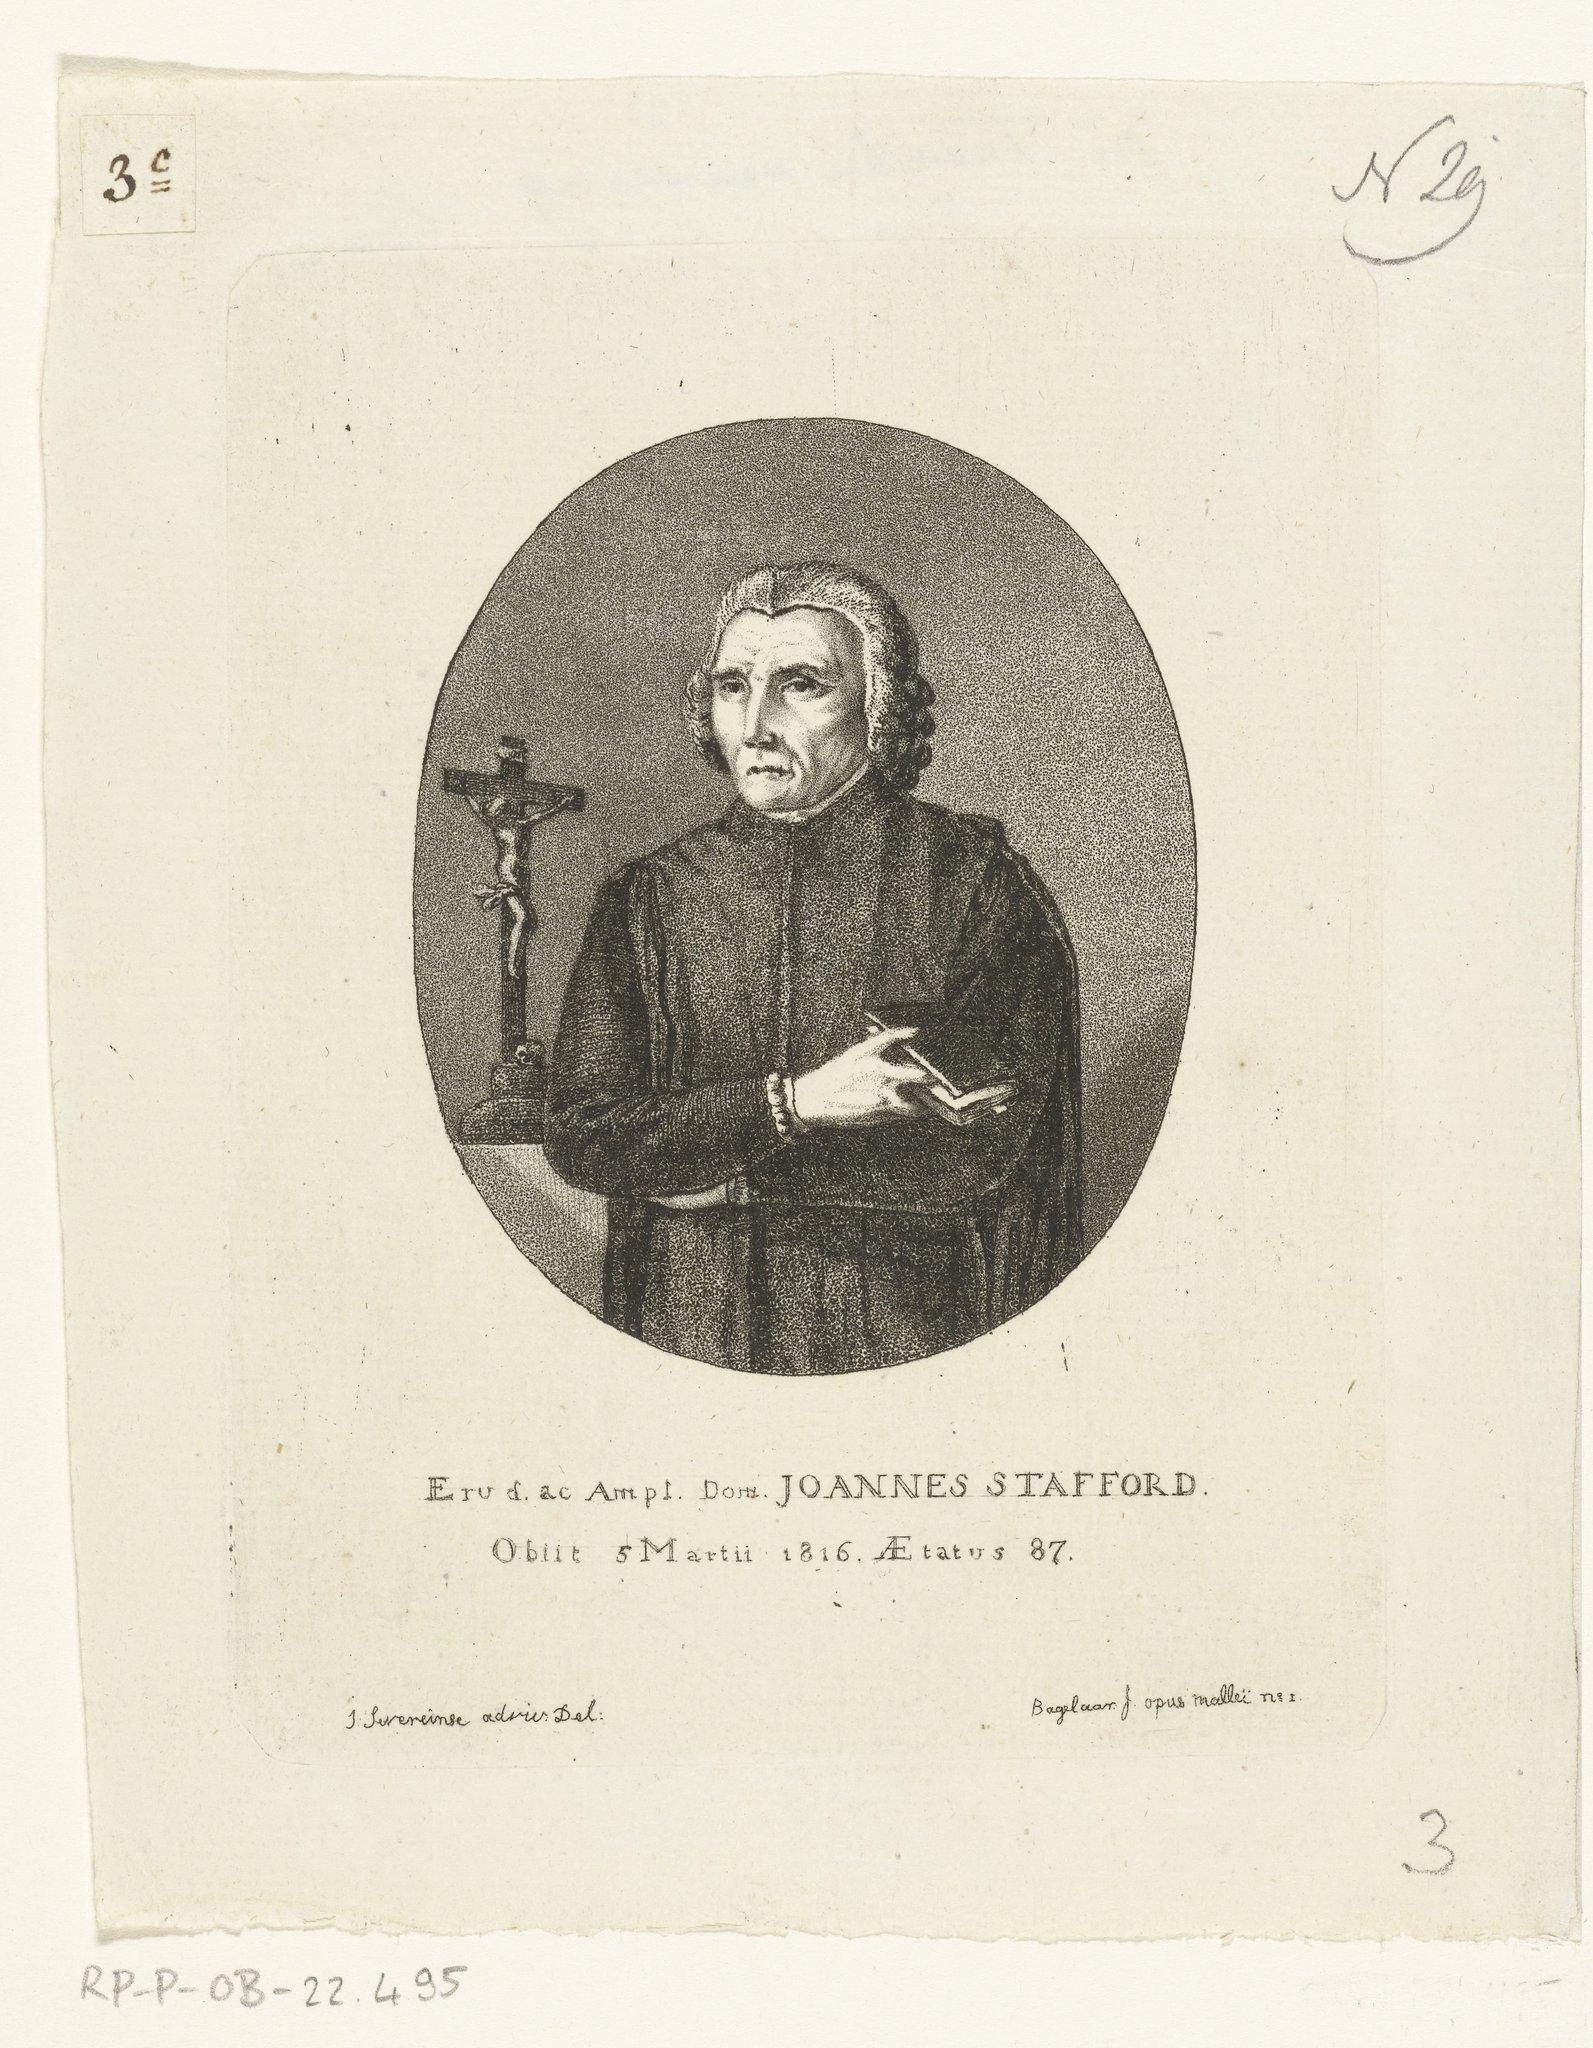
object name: print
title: Portret van Joannes Stafford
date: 1798-1837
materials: paper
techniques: aquatint, etching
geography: netherlands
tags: pastoor, joannes stafford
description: Portret van pastoor Joannes Stafford ten halven lijve met boek in zijn hand. Onder het portret zijn naam en sterfdatum.